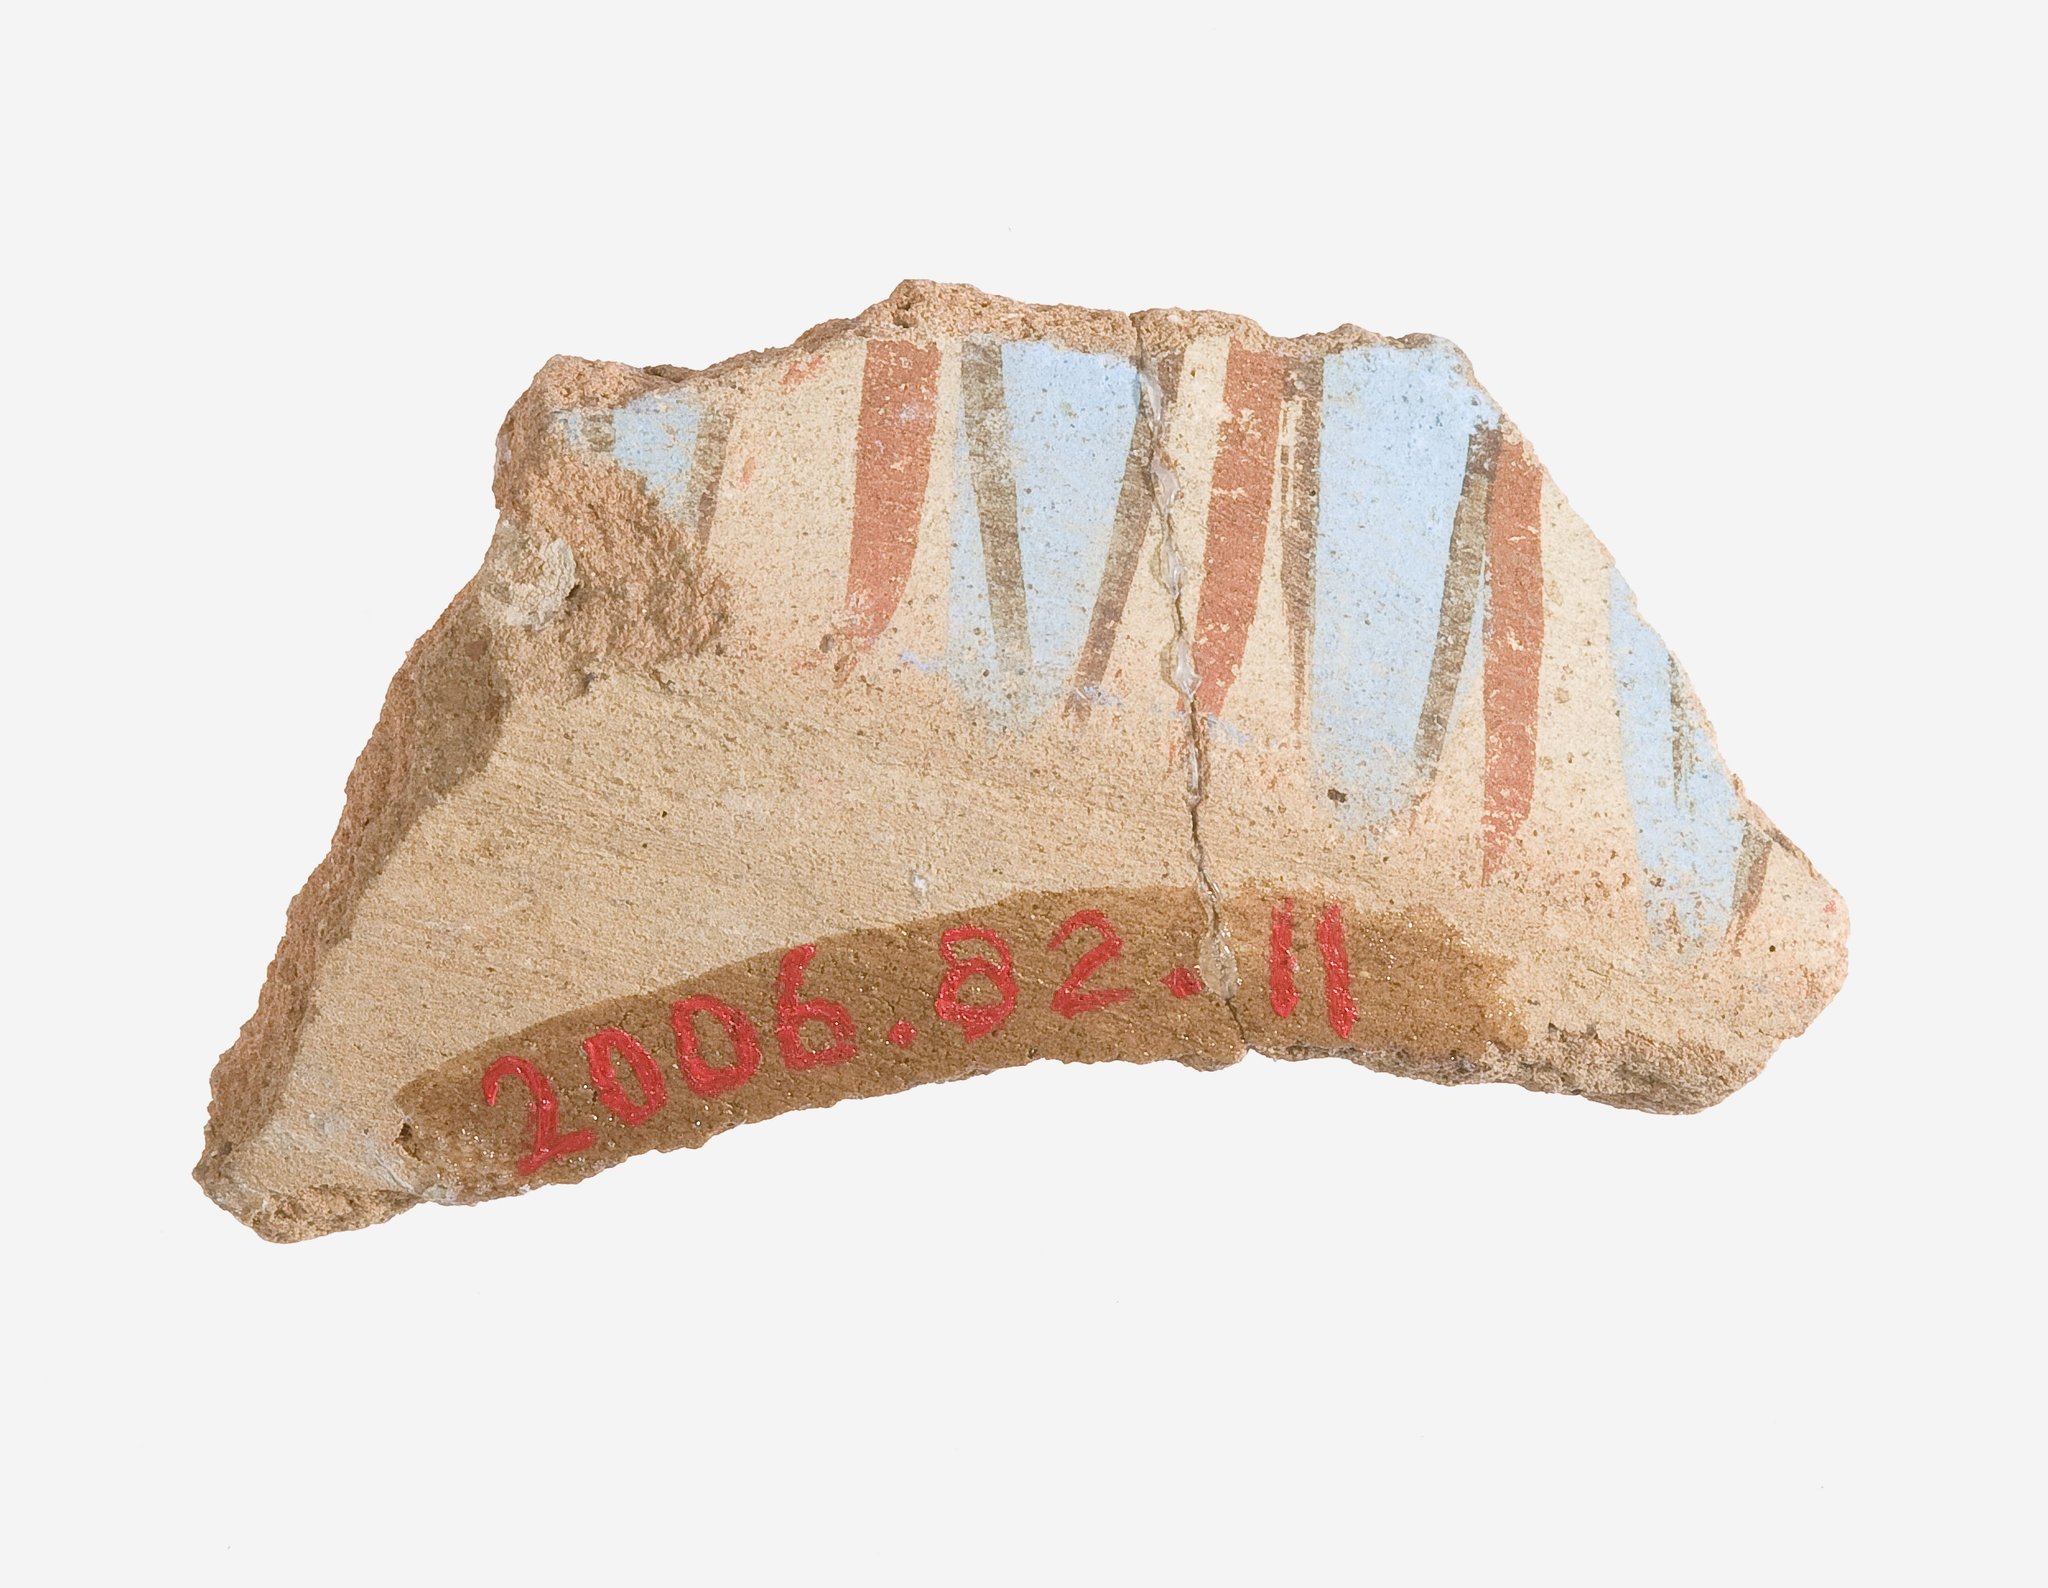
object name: vessel fragment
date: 1390-1352 BCE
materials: paint, pottery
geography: egypt